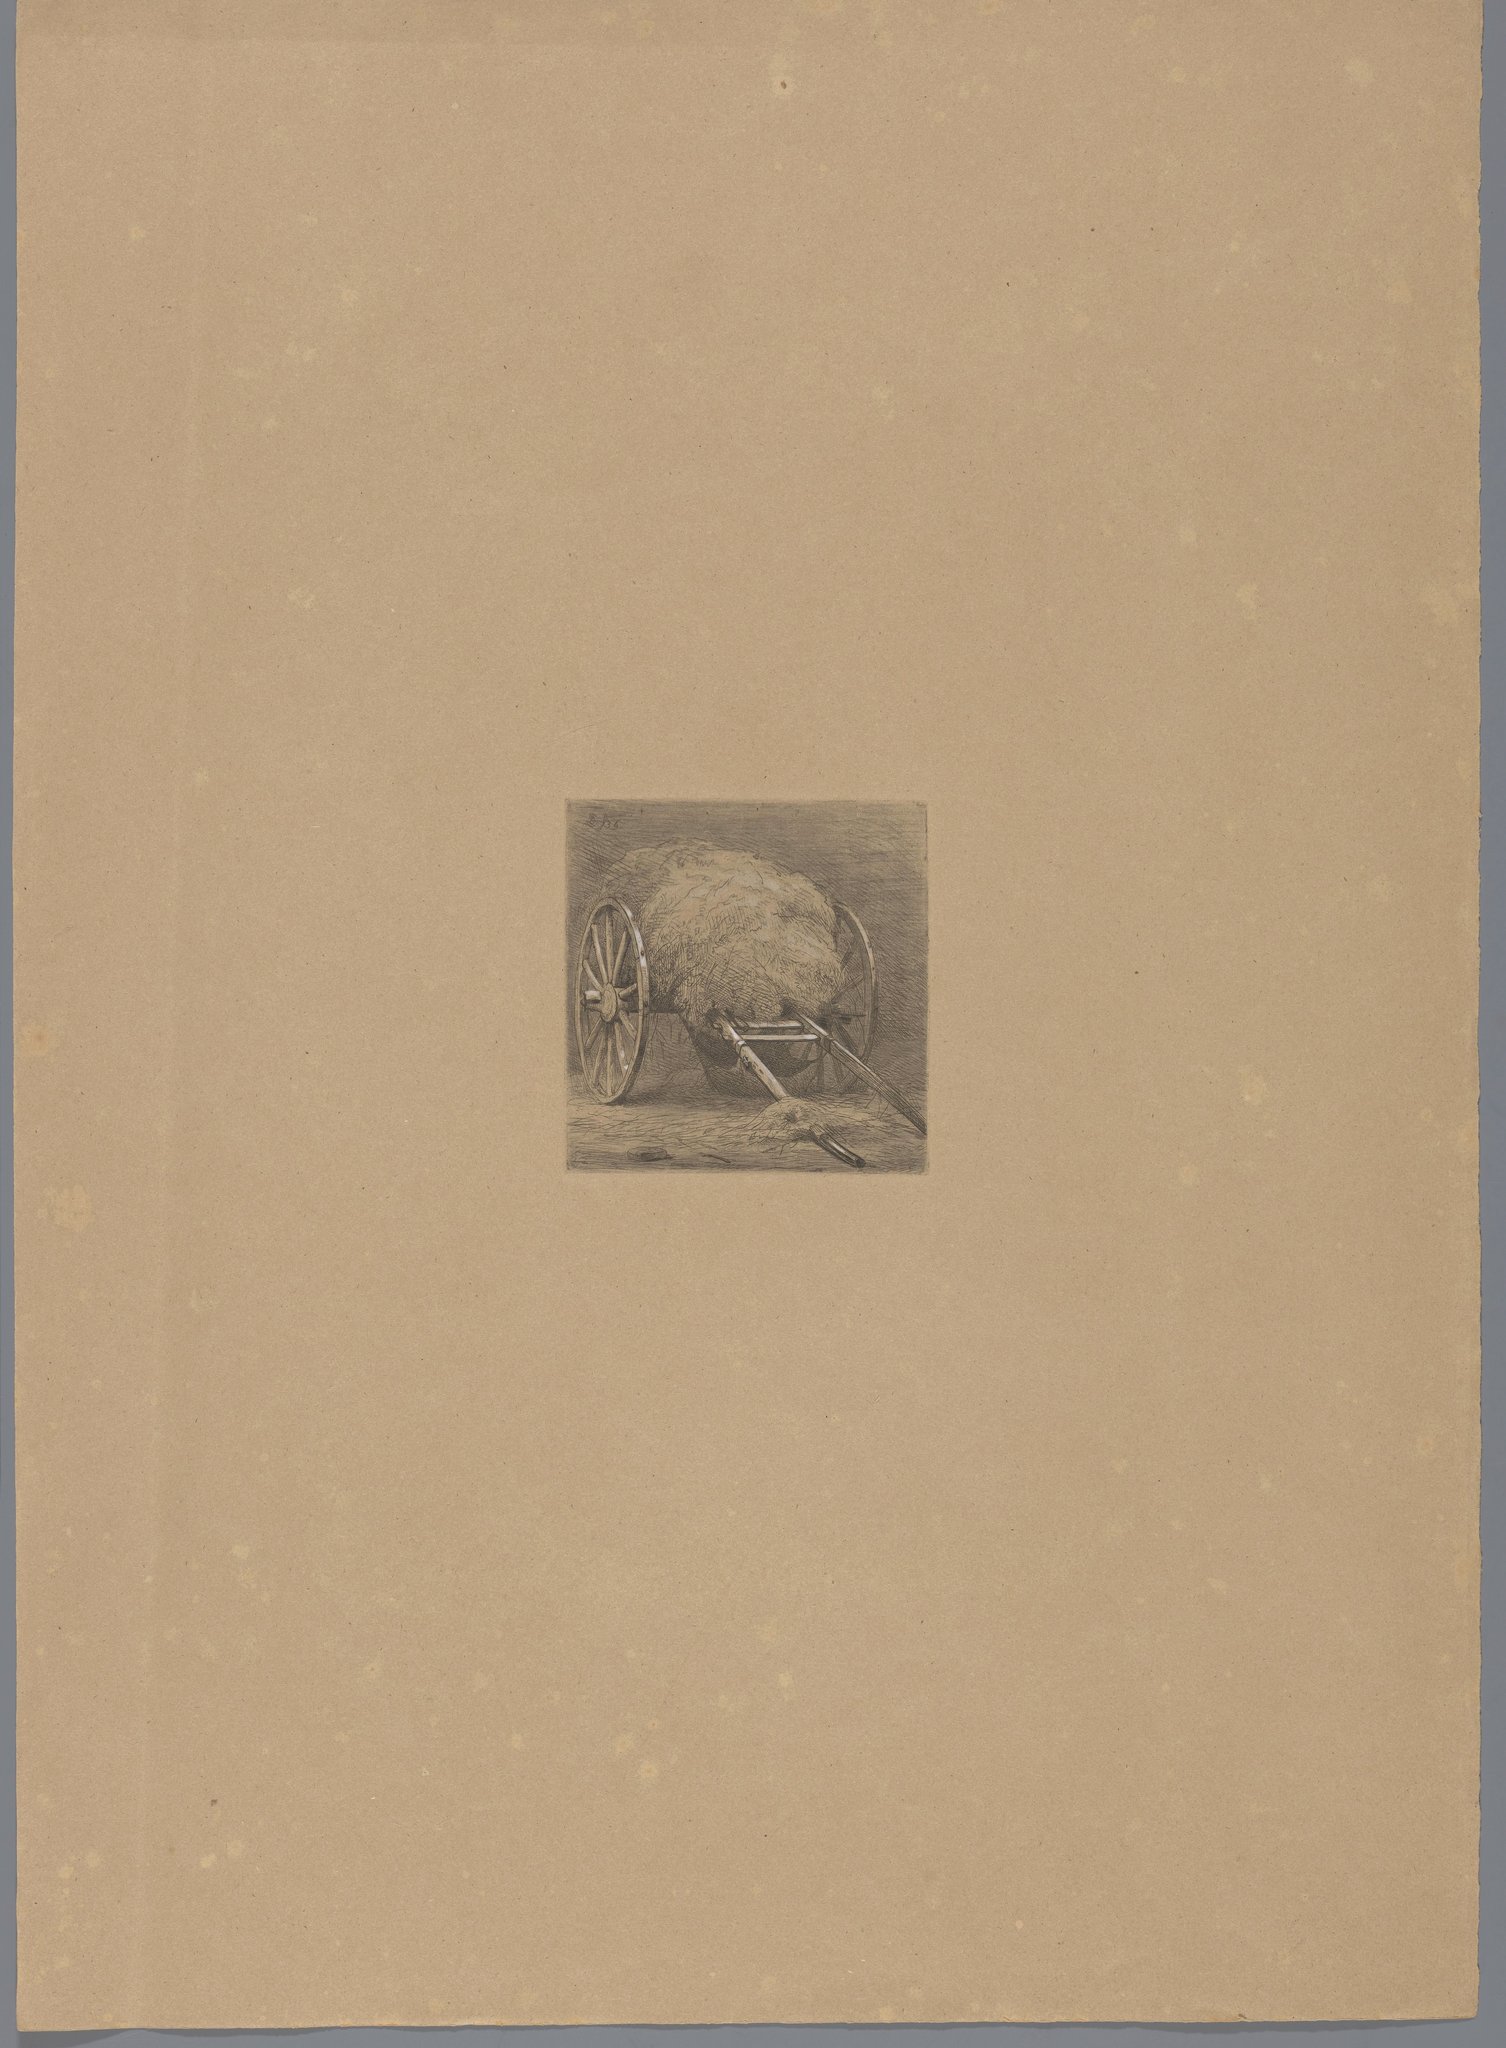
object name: print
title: Vijf etsproeven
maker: pierre louis dubourcq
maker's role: draughtsman, painter, print maker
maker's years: 1815-1873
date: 1836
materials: paper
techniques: brush, drypoint, etching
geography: netherlands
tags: hay-wagon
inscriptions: collector's mark: Lugt 2228